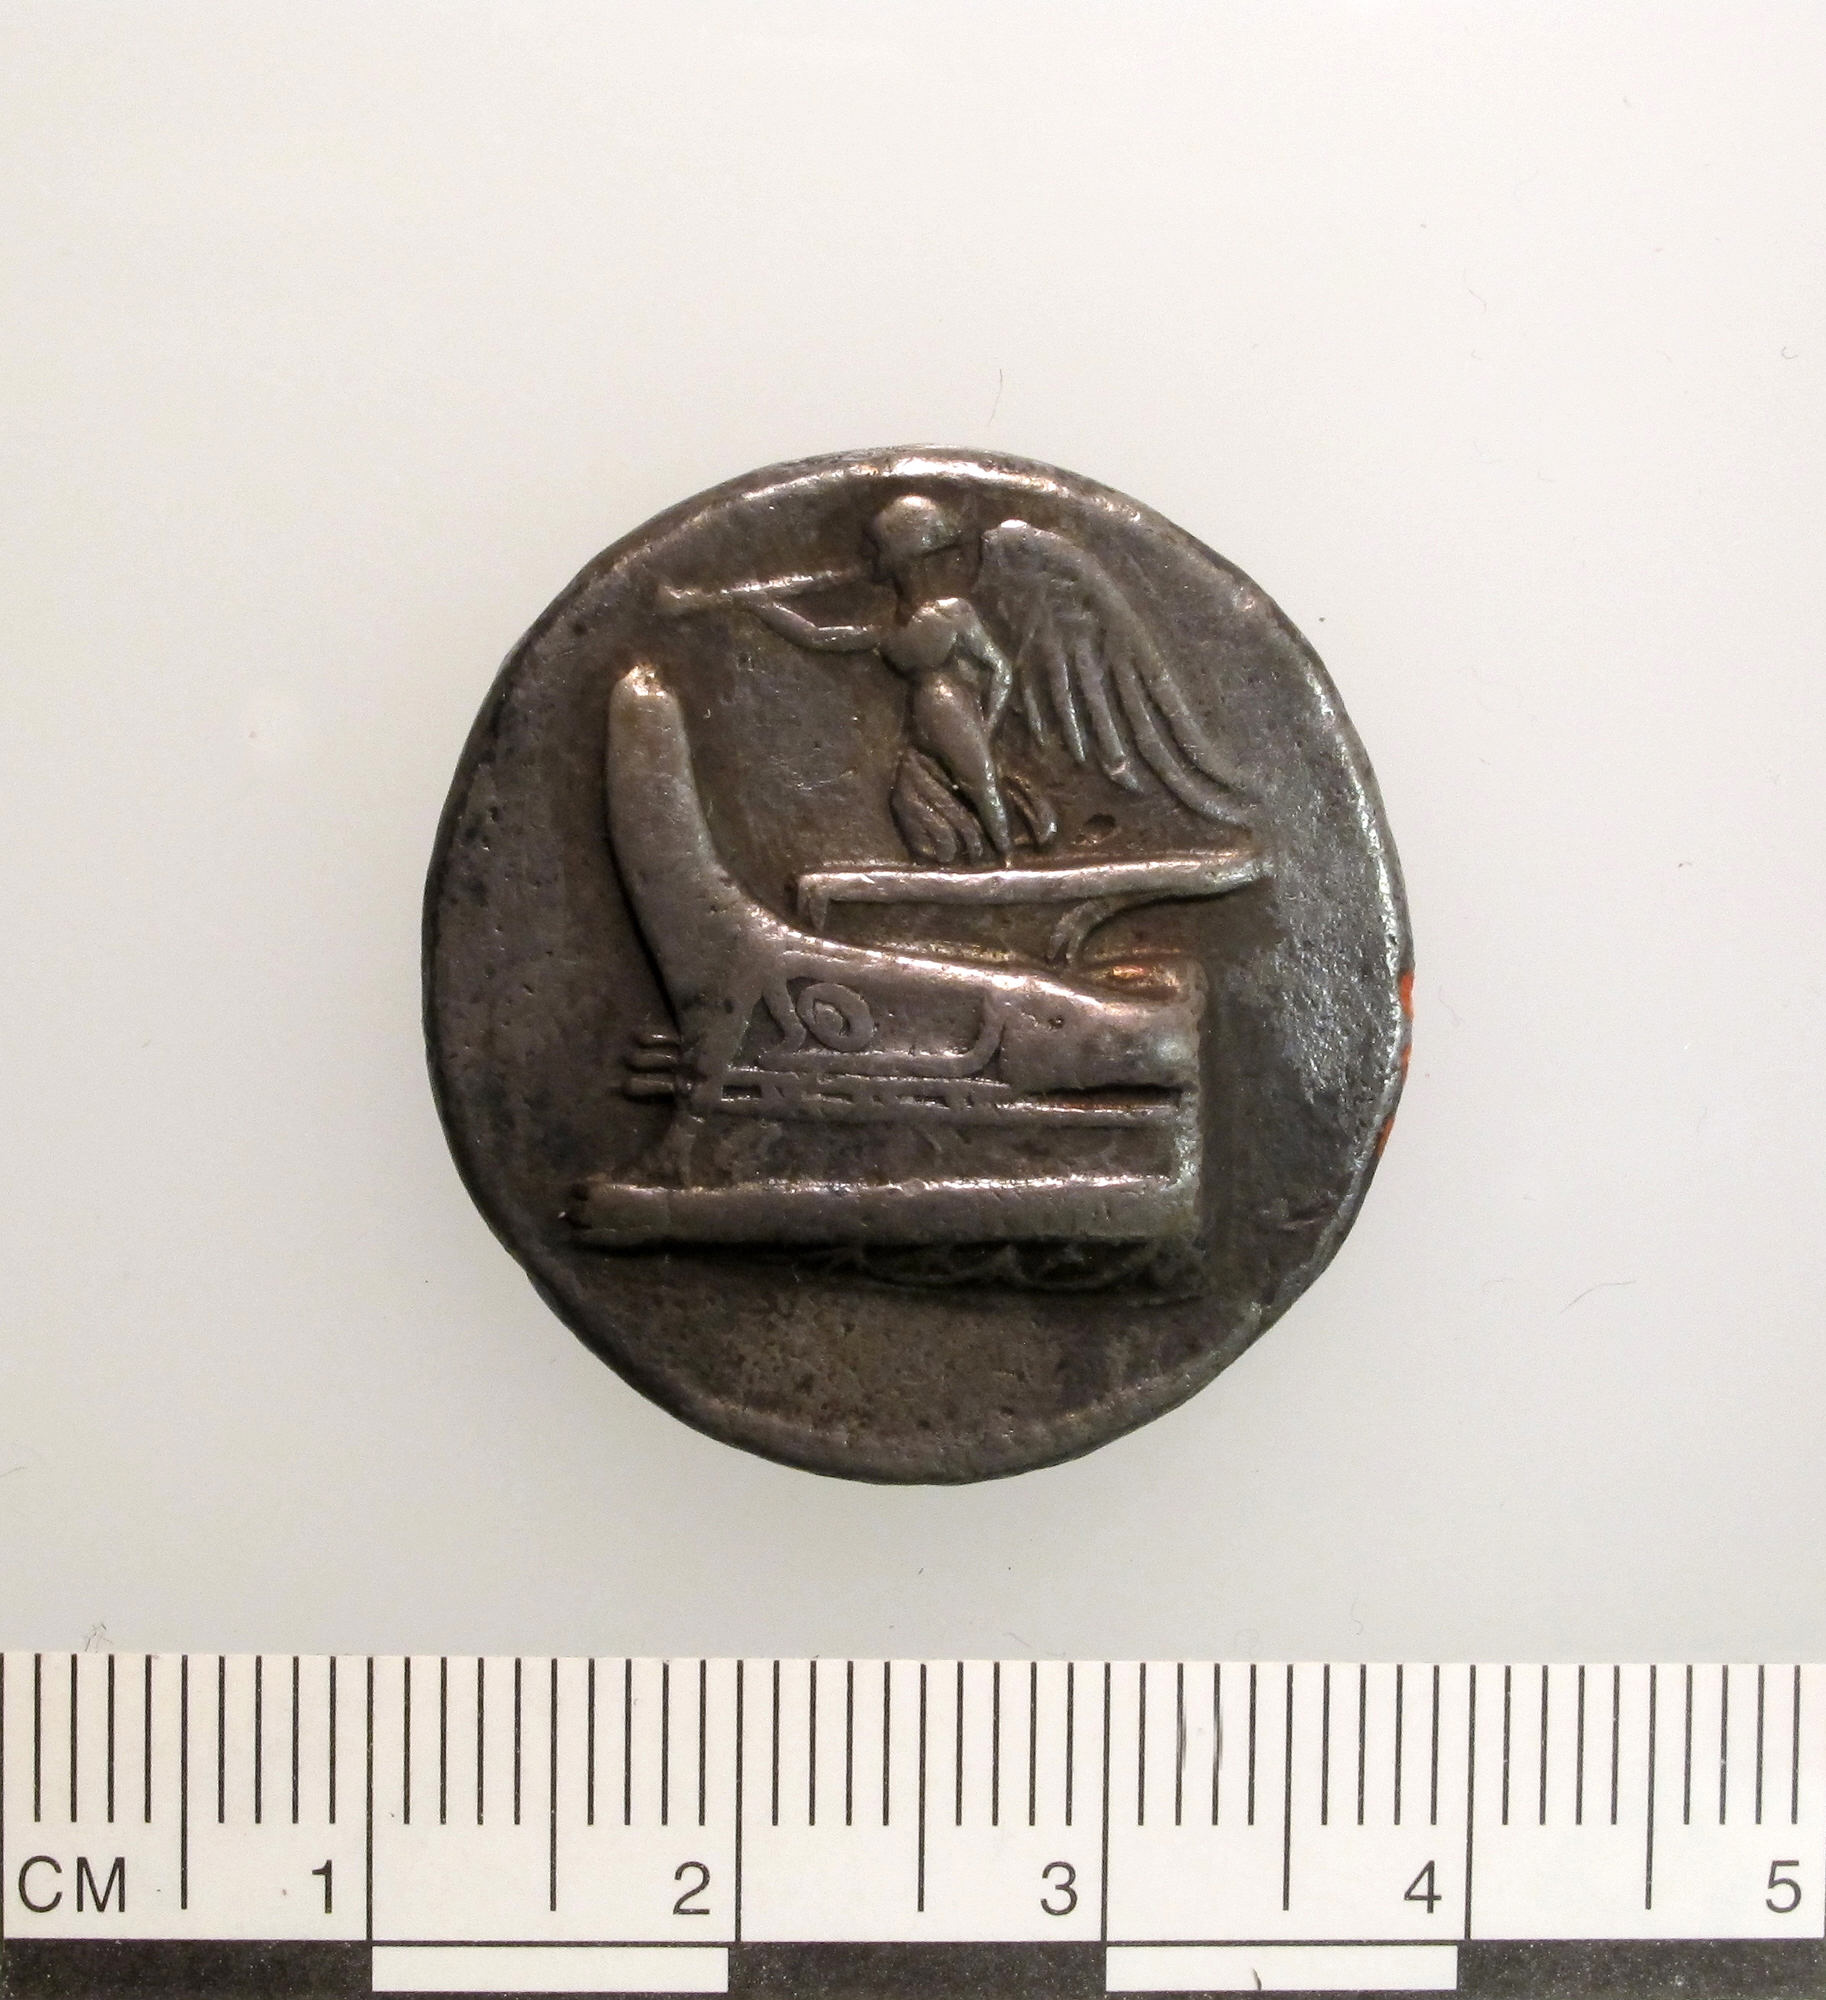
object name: tetradrachm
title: Silver tetradrachm of Demetrios Poliorketes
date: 300-294 BCE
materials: silver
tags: trumpets,nike,coins,ships